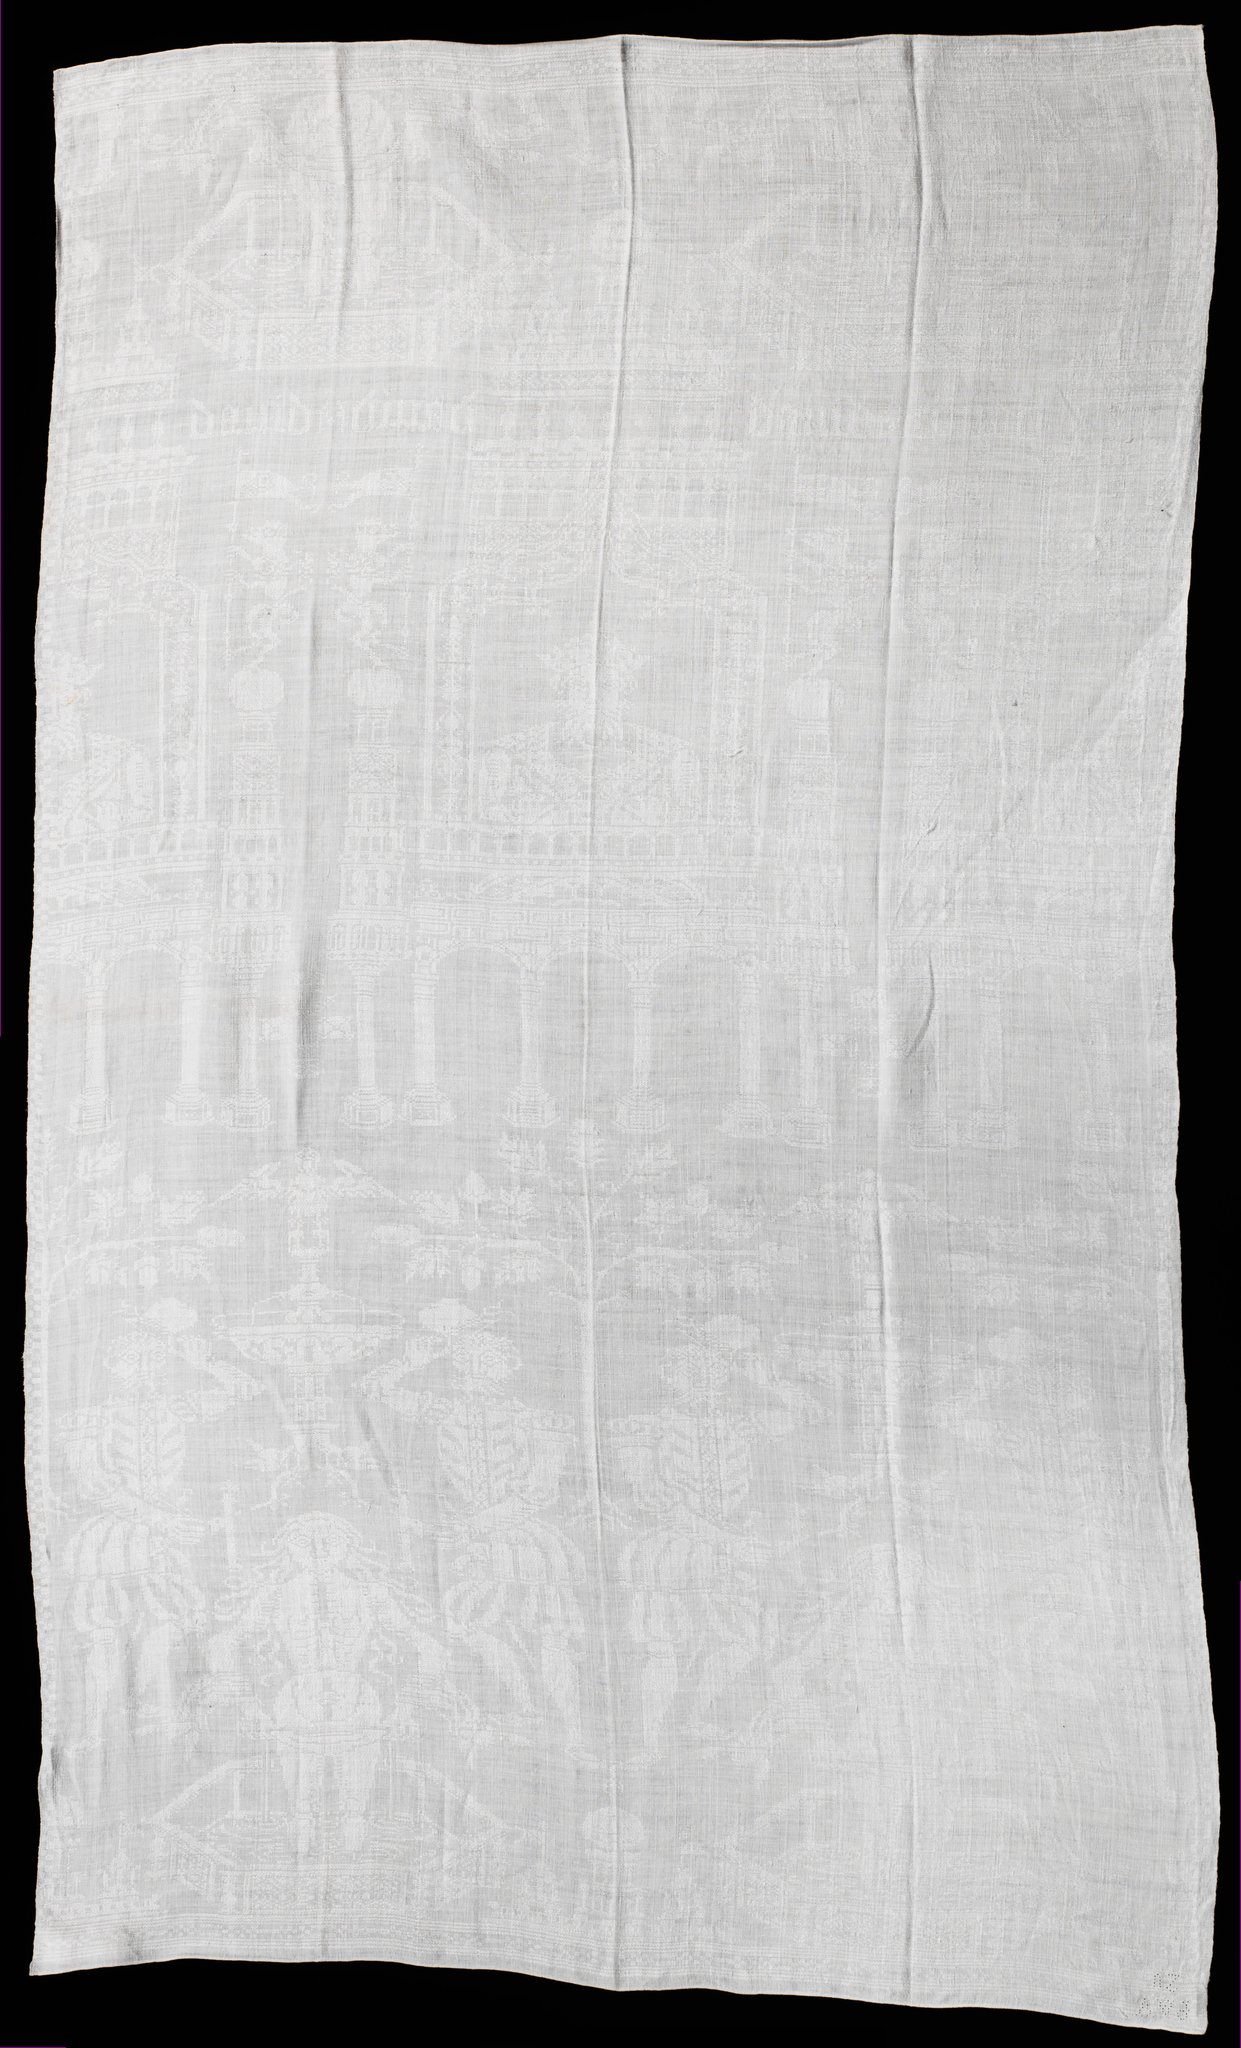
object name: napkin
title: Napkin with David and Bathsheba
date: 1590-1600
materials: linen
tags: bathsheba,david